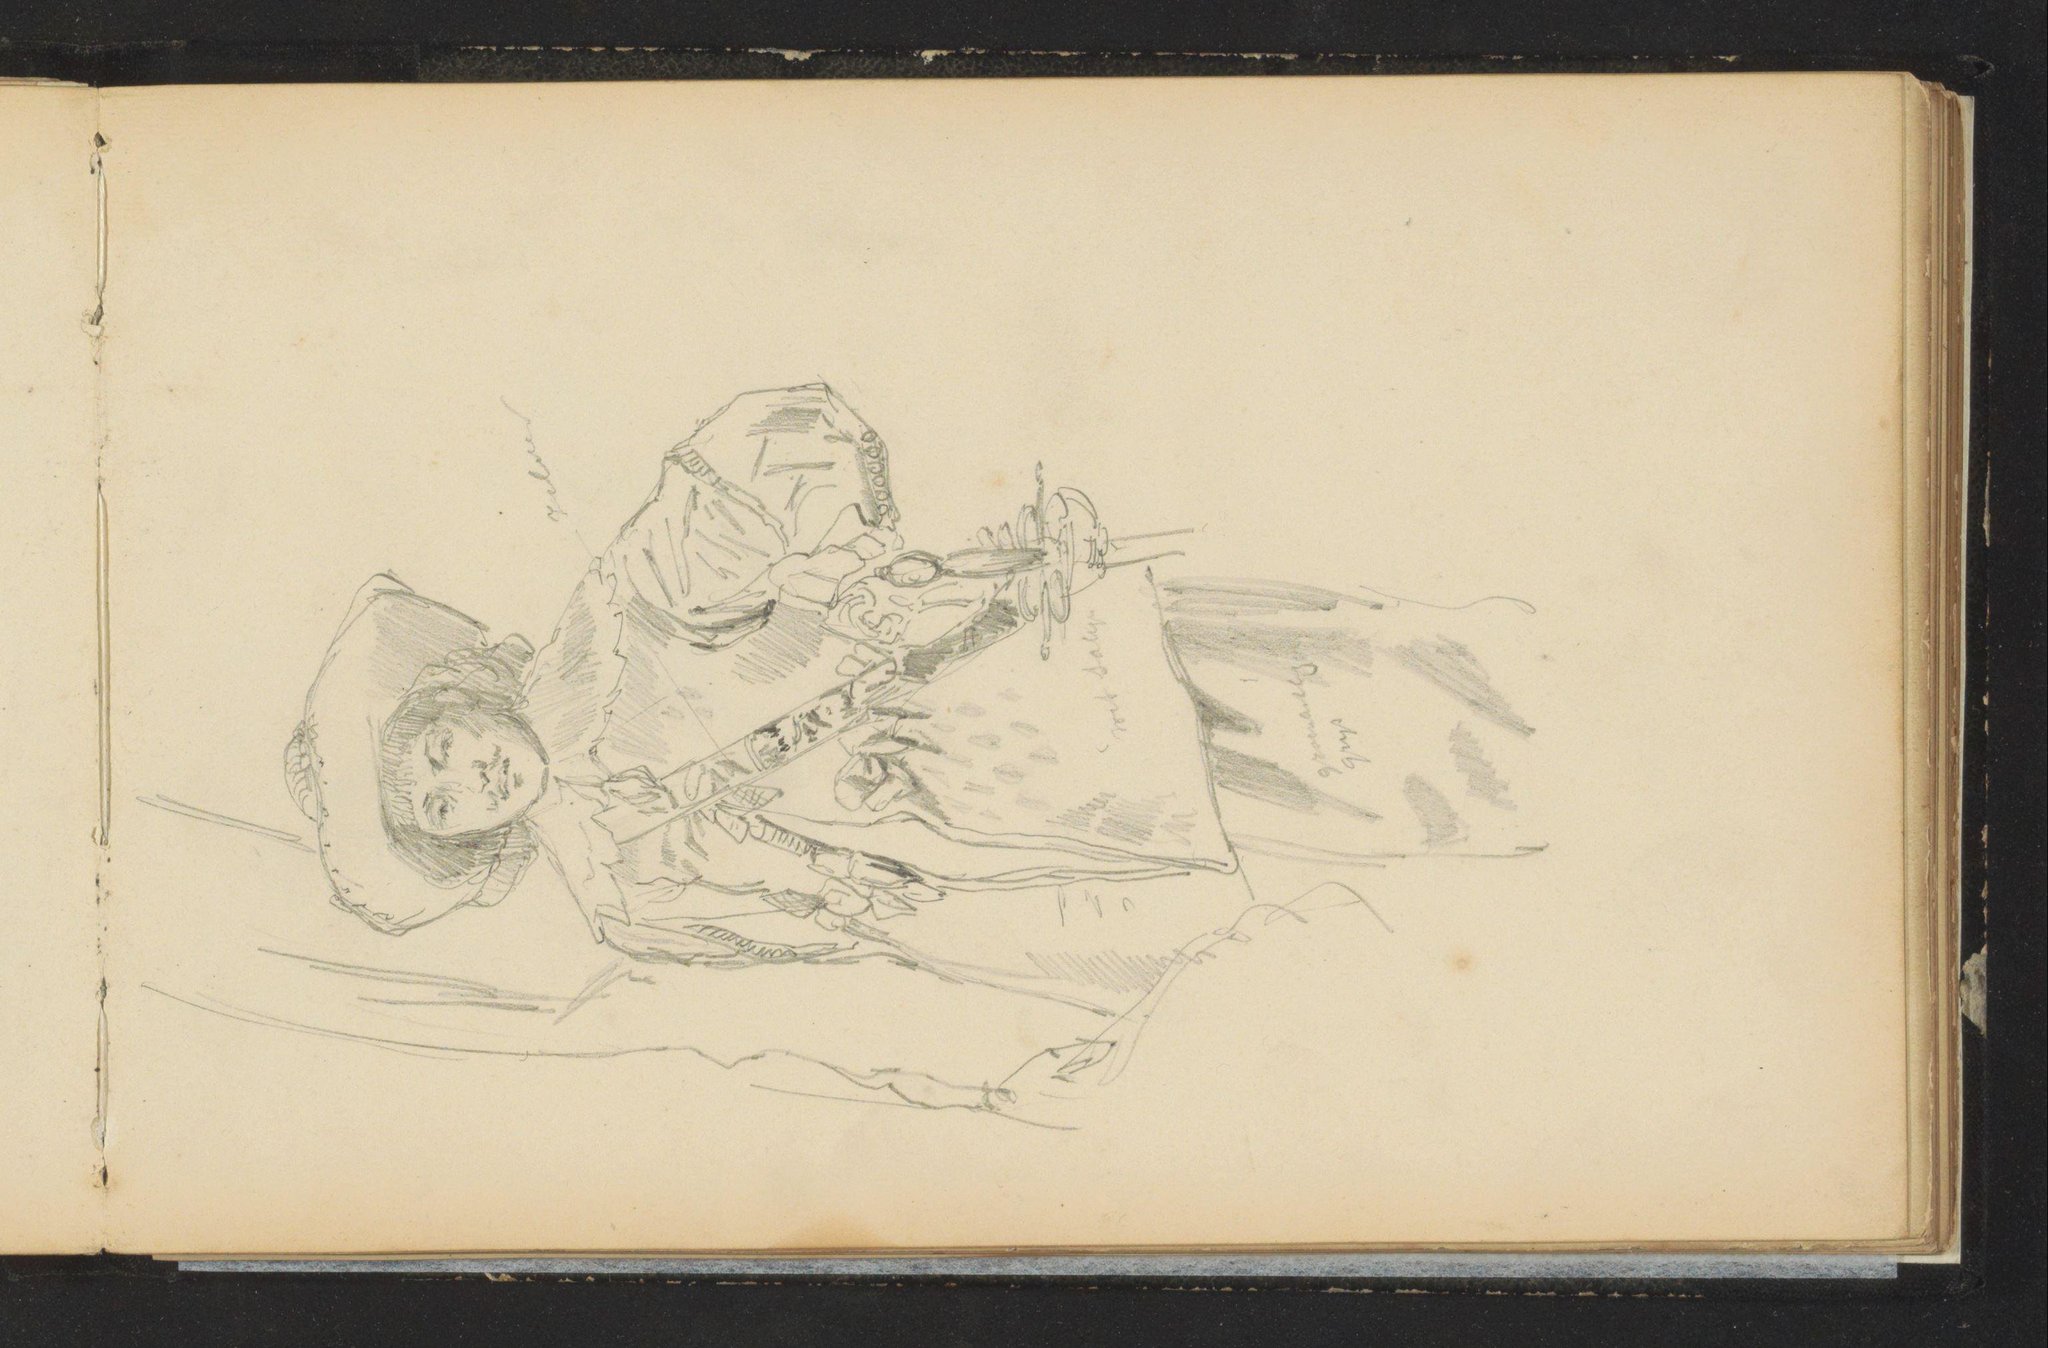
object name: sketchbook leaf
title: Man in zeventiende-eeuwse kleding, mogelijk een schutter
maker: cornelis springer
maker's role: draughtsman, painter, print maker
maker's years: 1817-1891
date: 1846-1882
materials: paper, pencil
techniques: stumping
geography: netherlands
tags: adult man, head-gear: hat (+ men's clothes), clothes, costume (+ men's clothes)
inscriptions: annotation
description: Man in zeventiende-eeuwse kleding, mogelijk een schutter, voor een vlag of draperie. Blad 50 uit een schetsboek met 91 bladen.